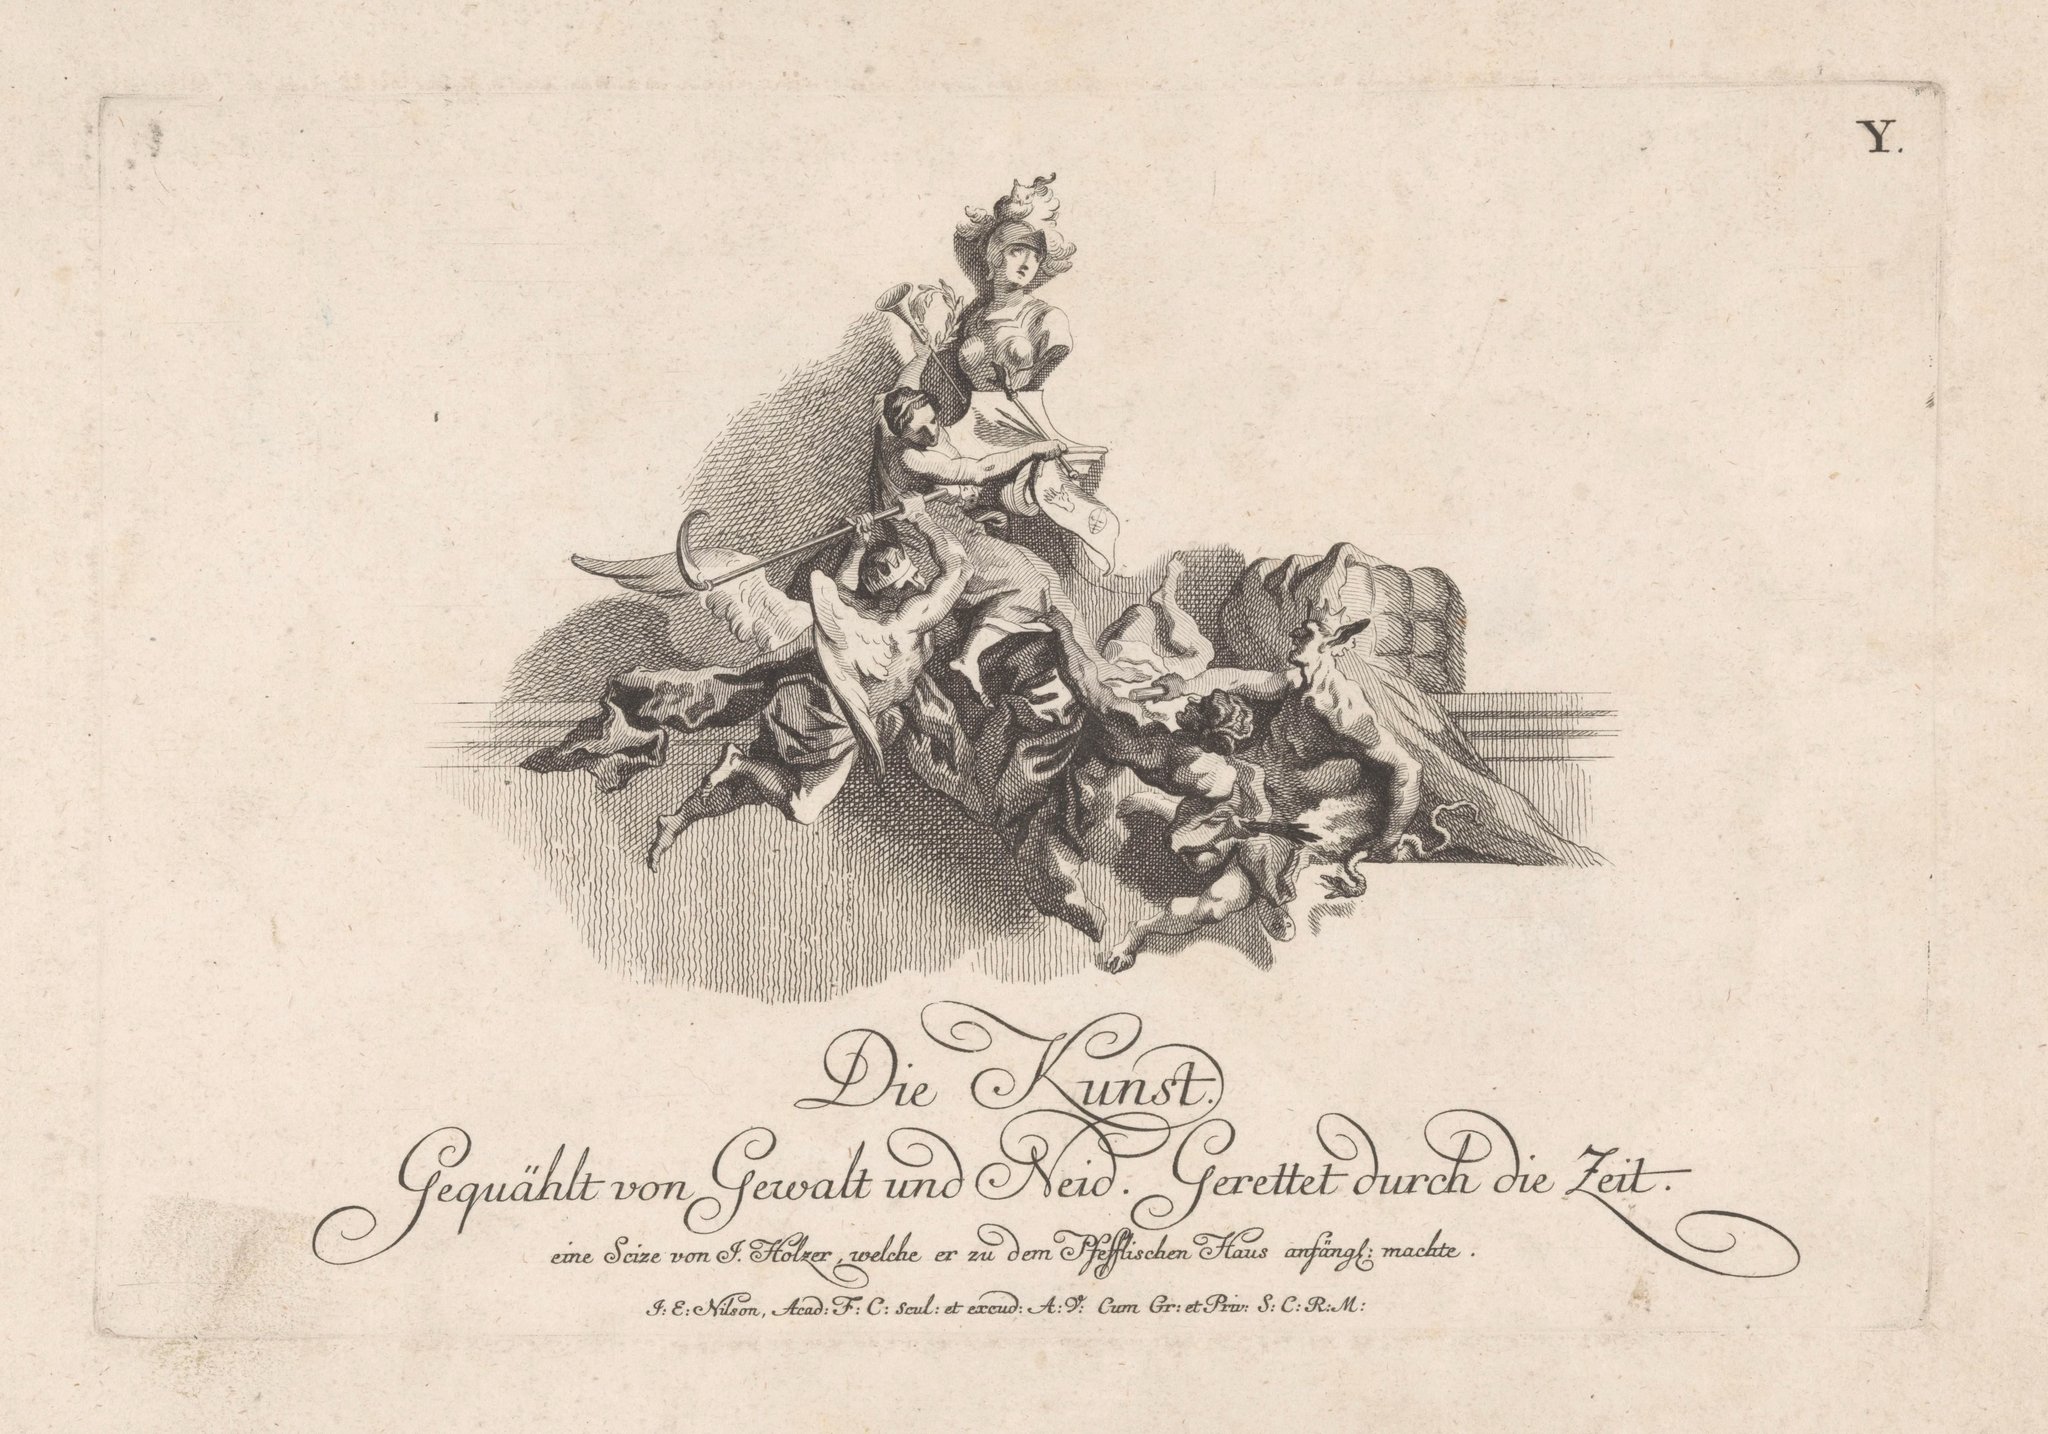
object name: print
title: Geweld en nijd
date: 1765-1770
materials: paper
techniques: engraving, etching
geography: augsburg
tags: envy; 'invidia' (ripa) ~ personification of one of the seven deadly sins, (story of) minerva (pallas, athena), symbolic representations, allegories and emblems ~ art; 'arte' (ripa), father time, man with wings and scythe, the greek heroic legends (ii): heroes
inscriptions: collector's mark: Lugt 2760, collector's mark: Lugt 2228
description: Allegorie van geweld en nijd. Een vrouwelijke personificatie van de kunsten zoekt bescherming bij een Minervabuste. Minerva staat symbool voor wijsheid en strijd. Koning Midas en Medusa, de personificaties van geweld en nijd, naderen rechts de personificatie van de kunsten en trekken aan haar kleding. Links vliegt Vader Tijd en redt de kunsten met zijn zeis. In de ondermarge een Duitse tekst.